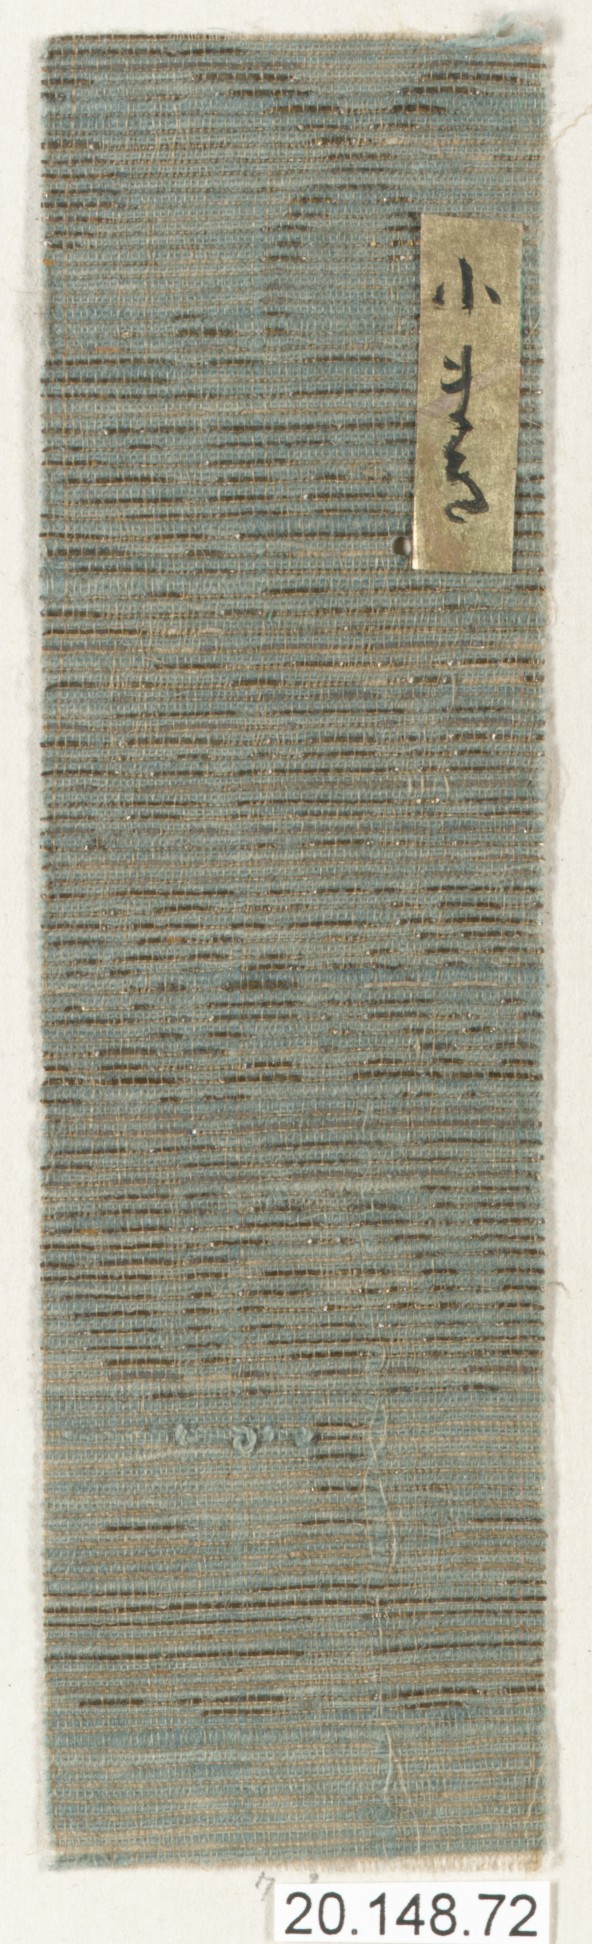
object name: piece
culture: japanese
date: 1501-1600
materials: silk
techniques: compound weave